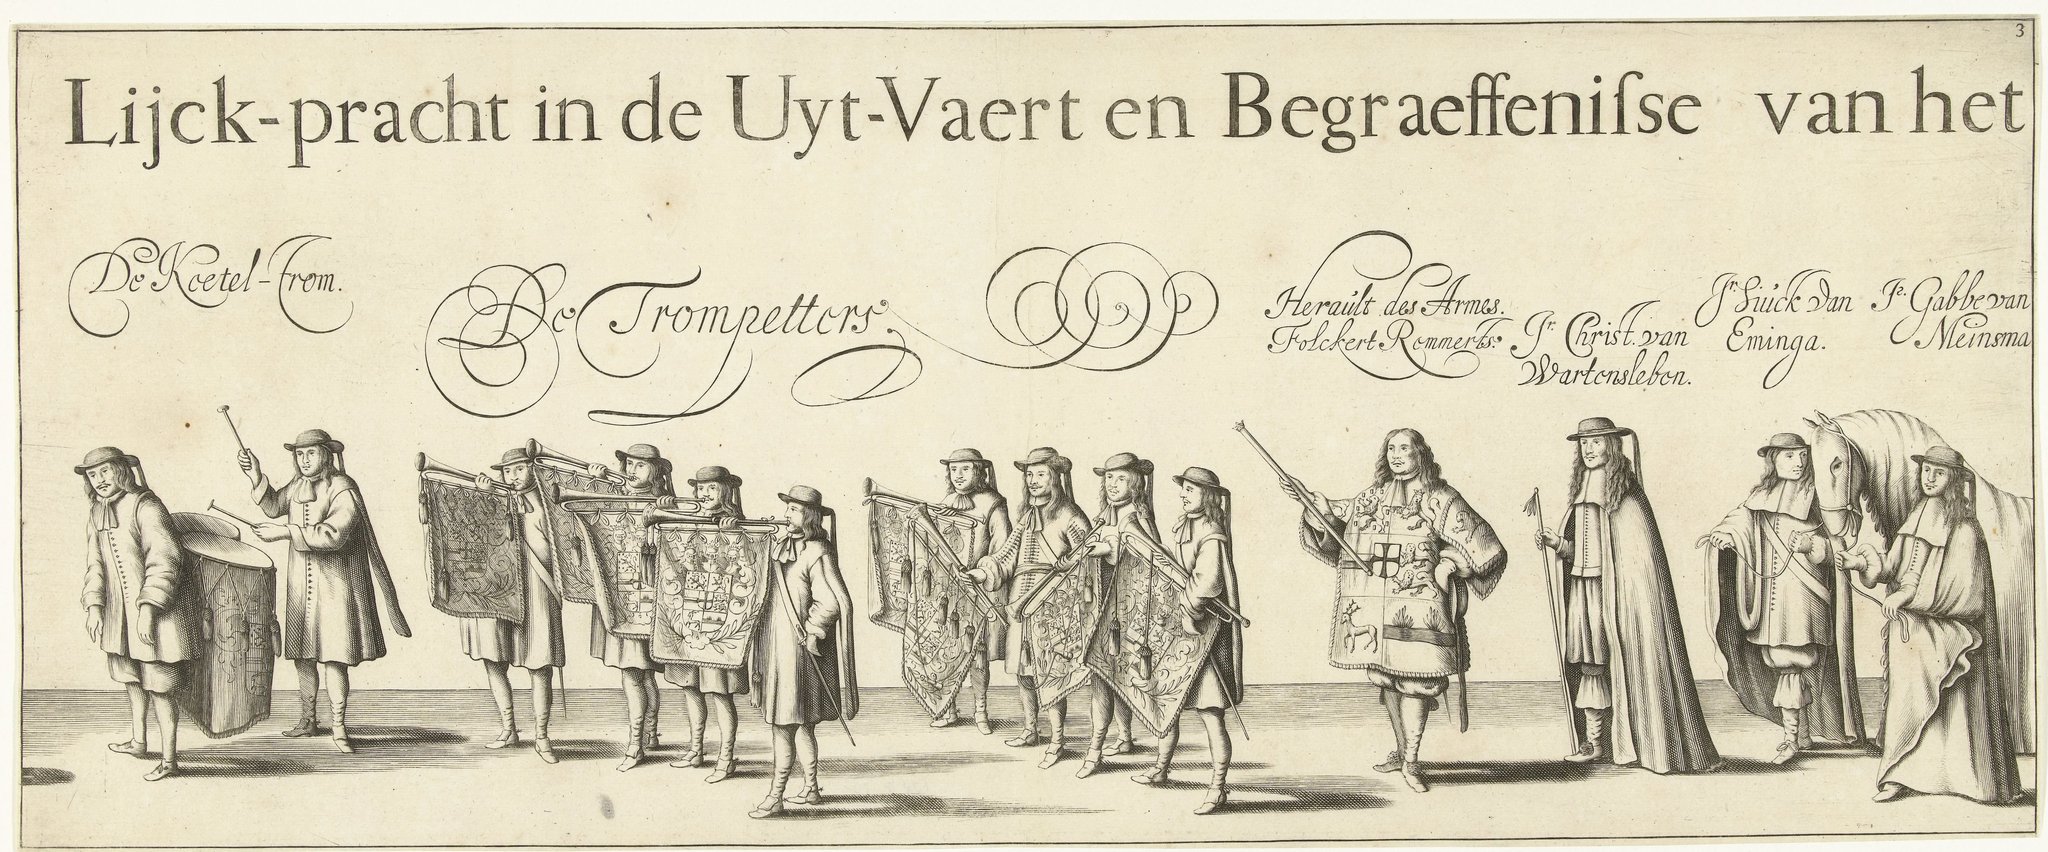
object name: print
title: Rouw-Staetelijcke Lijk-pracht in de Uyt-Vaert en Begraefenisse van het ont-zielde Lichaem van (...) Wilhelm Frederich (...) Overleden binnen Leeuwarden (...) den een-en-twintichsten October, MDCLXIV. en aldaer in 't Choor van de Jacobijner Kerck, den vyfthienden december MDCLXIV. Oude Stijl (...)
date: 1666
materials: paper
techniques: engraving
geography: leeuwarden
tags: arnhem, cortege, funeral procession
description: Begrafenisoptocht van Willem Frederik, graaf van Nassau-Dietz, in Leeuwarden op 6 januari 1665. Deel van de begrafenisstoet. Plaat nr. 3 in een ensemble van 24 (van de 25) ongemonteerde genummerde platen (zonder tekstbladen) die samen een lange fries vormen.